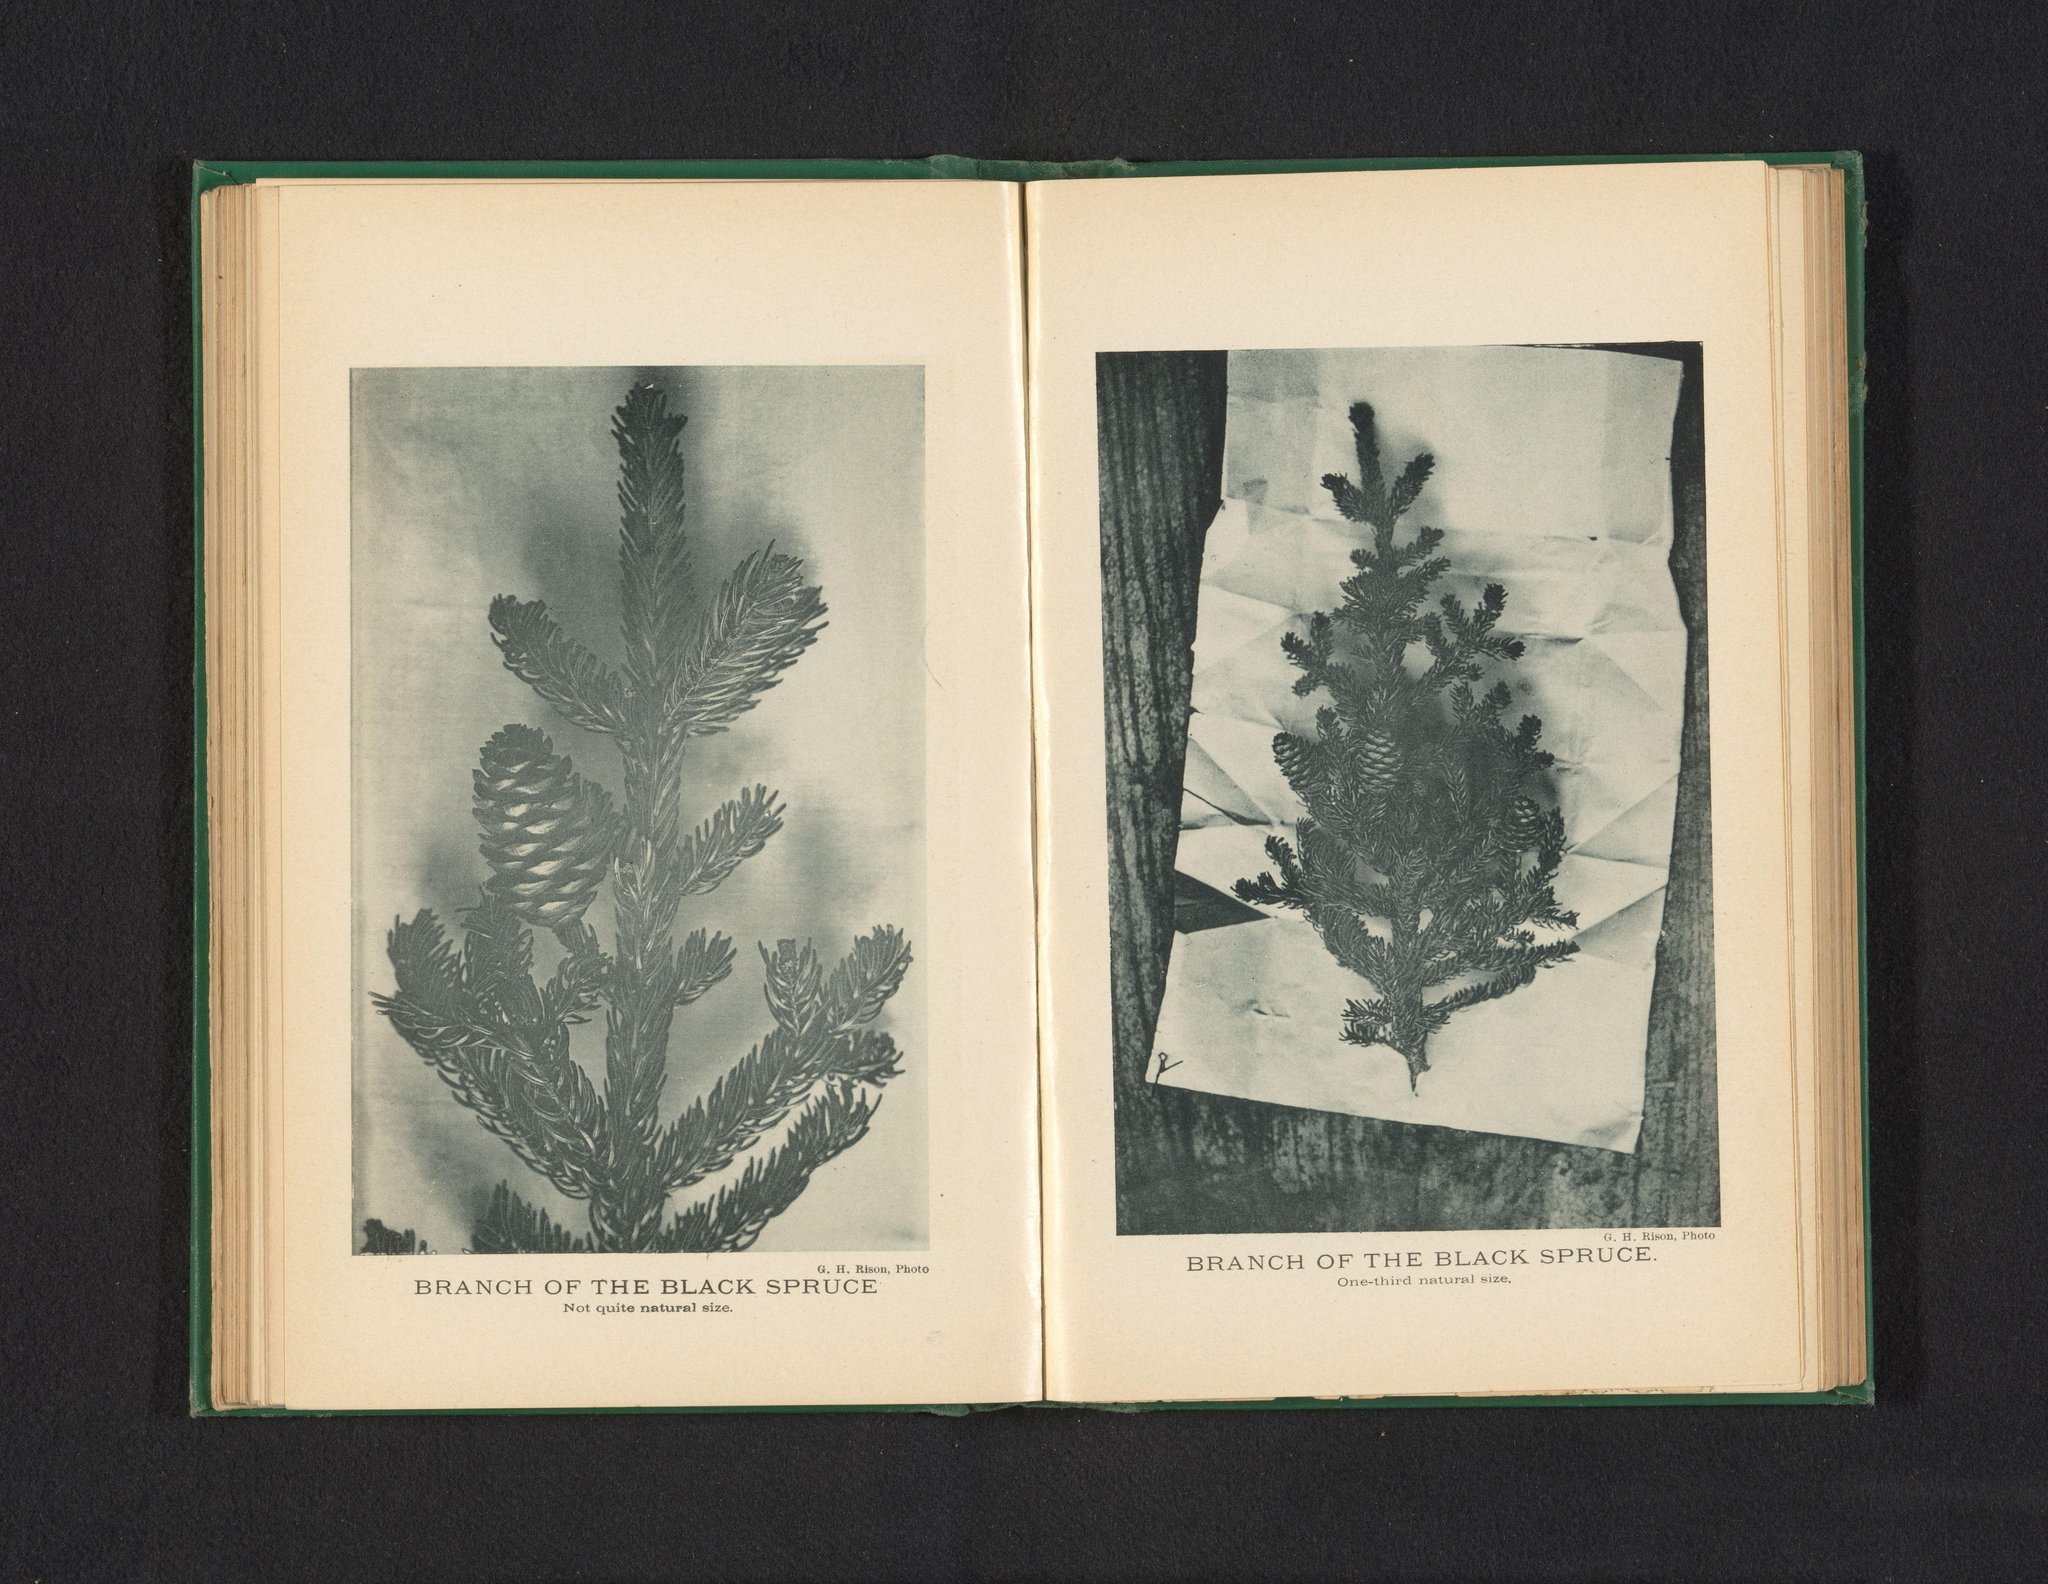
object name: photomechanical print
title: Branch of the black spruce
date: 1894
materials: paper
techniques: photograph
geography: new york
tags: trees: spruce (+ branch, stick)